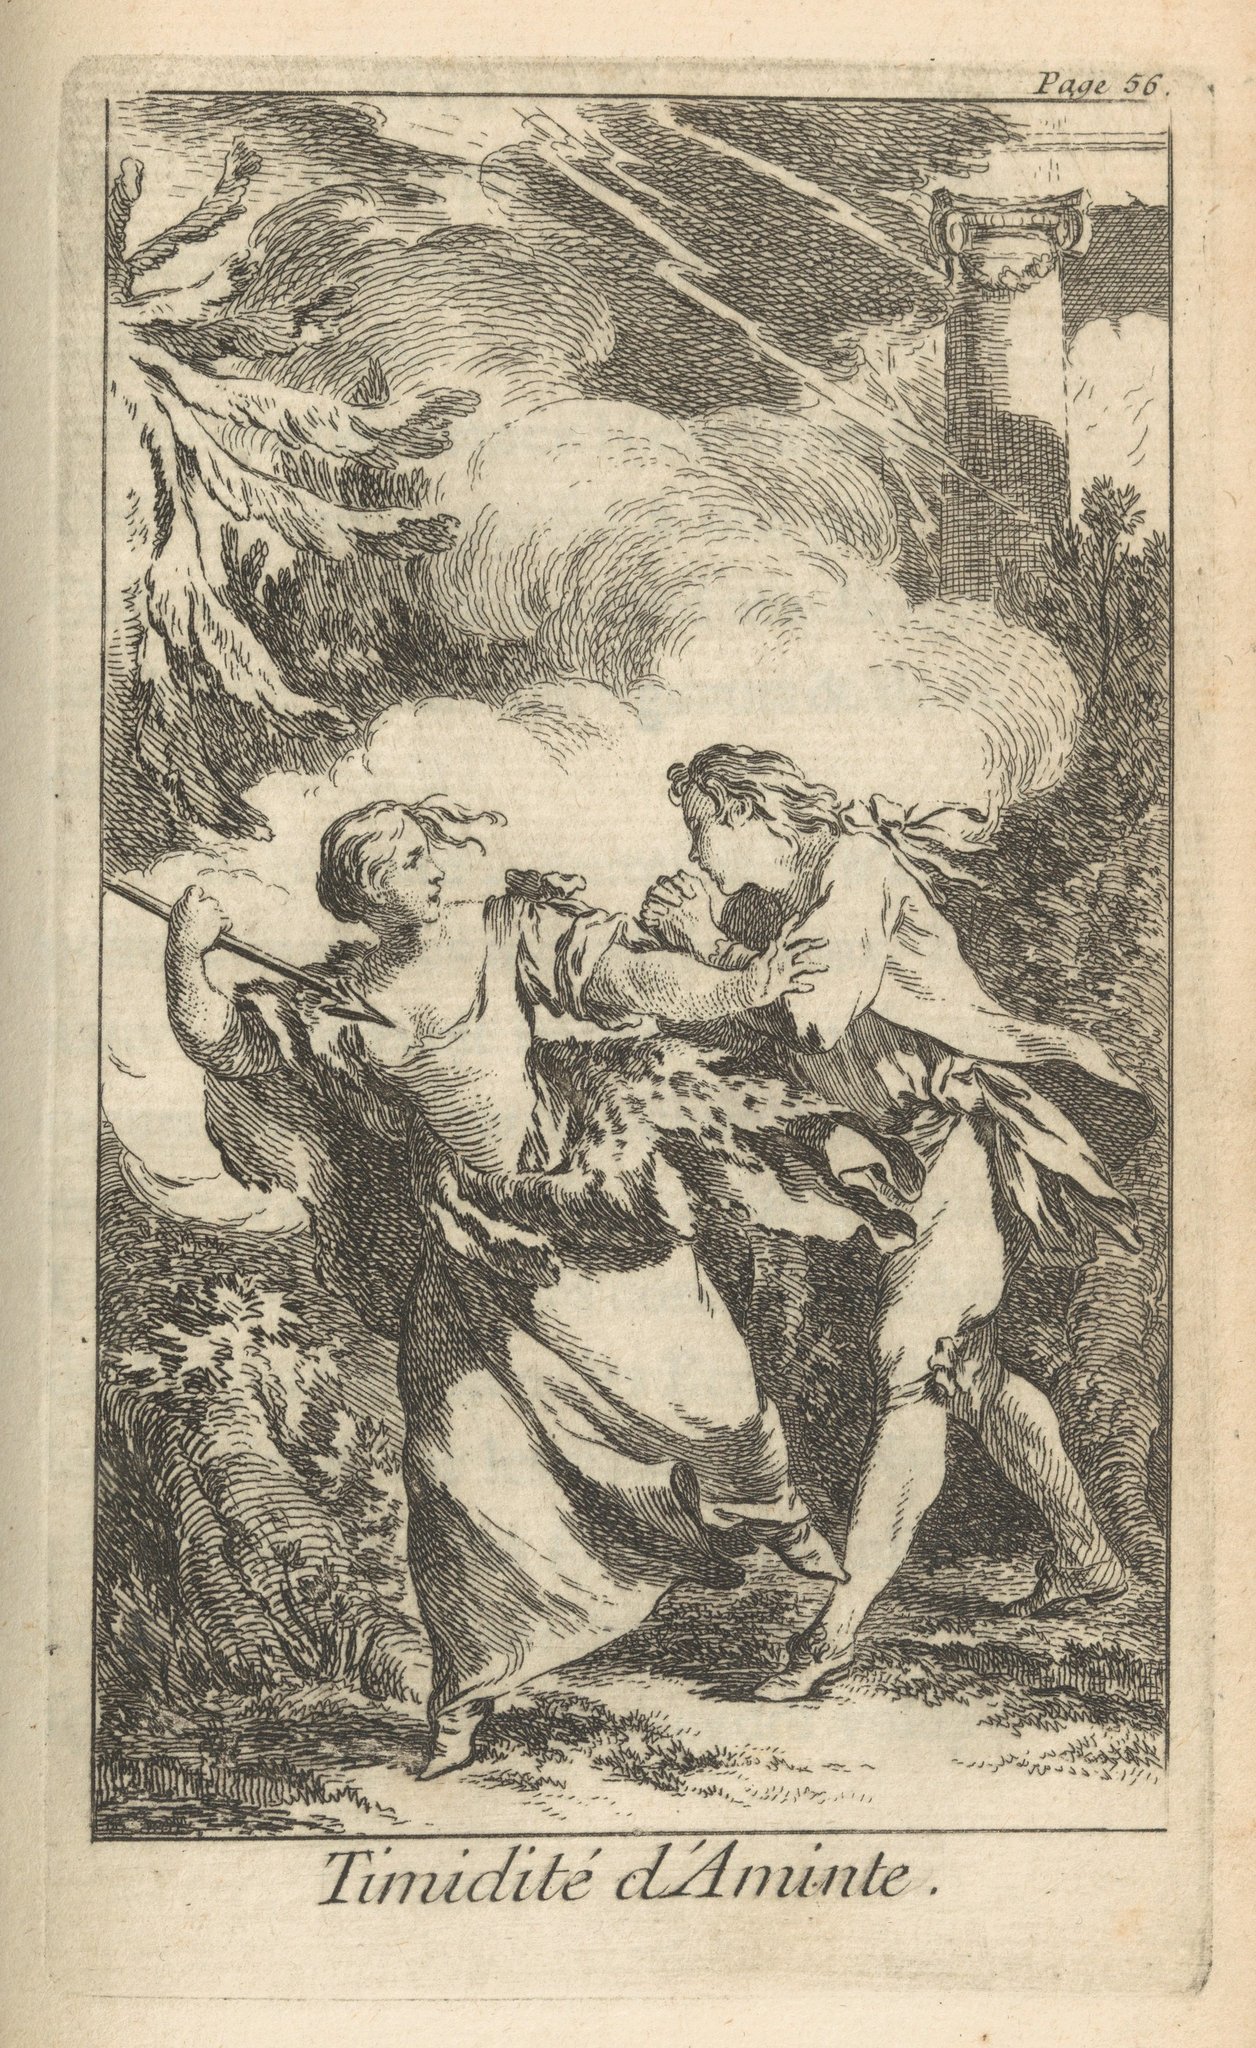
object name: book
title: Silvie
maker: claude henri watelet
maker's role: etcher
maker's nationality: french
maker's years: 1714-1789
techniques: etching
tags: spears,women